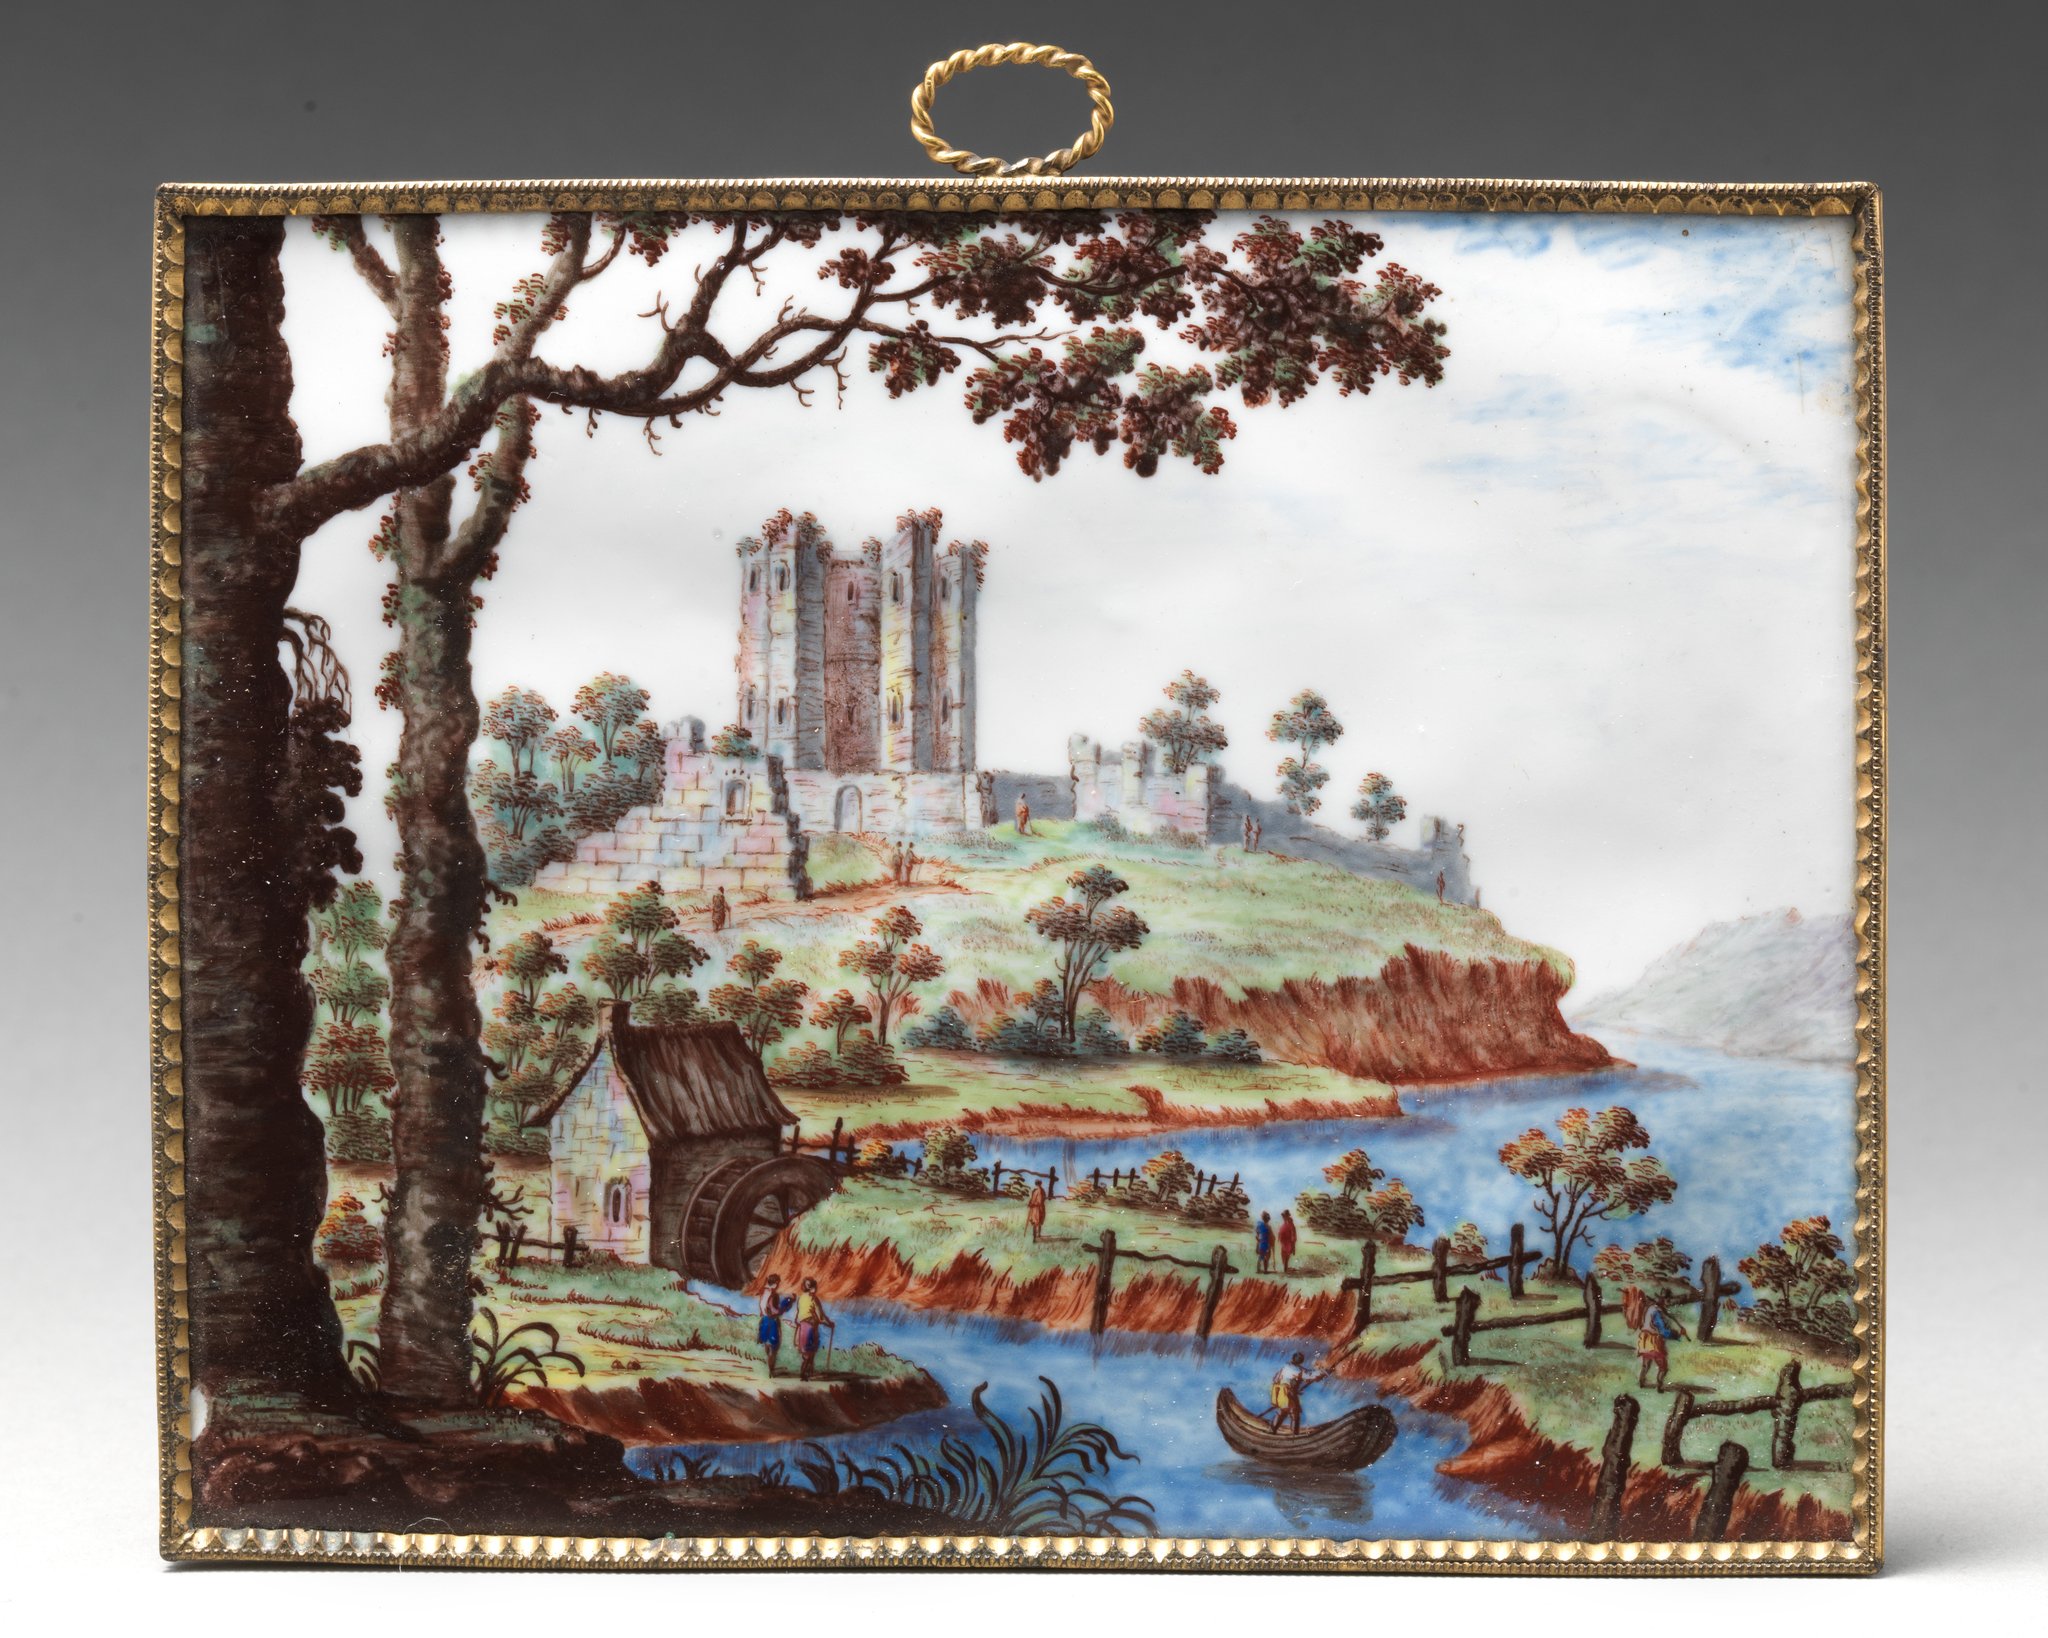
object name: plaque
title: Plaque with landscape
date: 1755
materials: copper, enamel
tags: castles,rivers,landscapes,boats